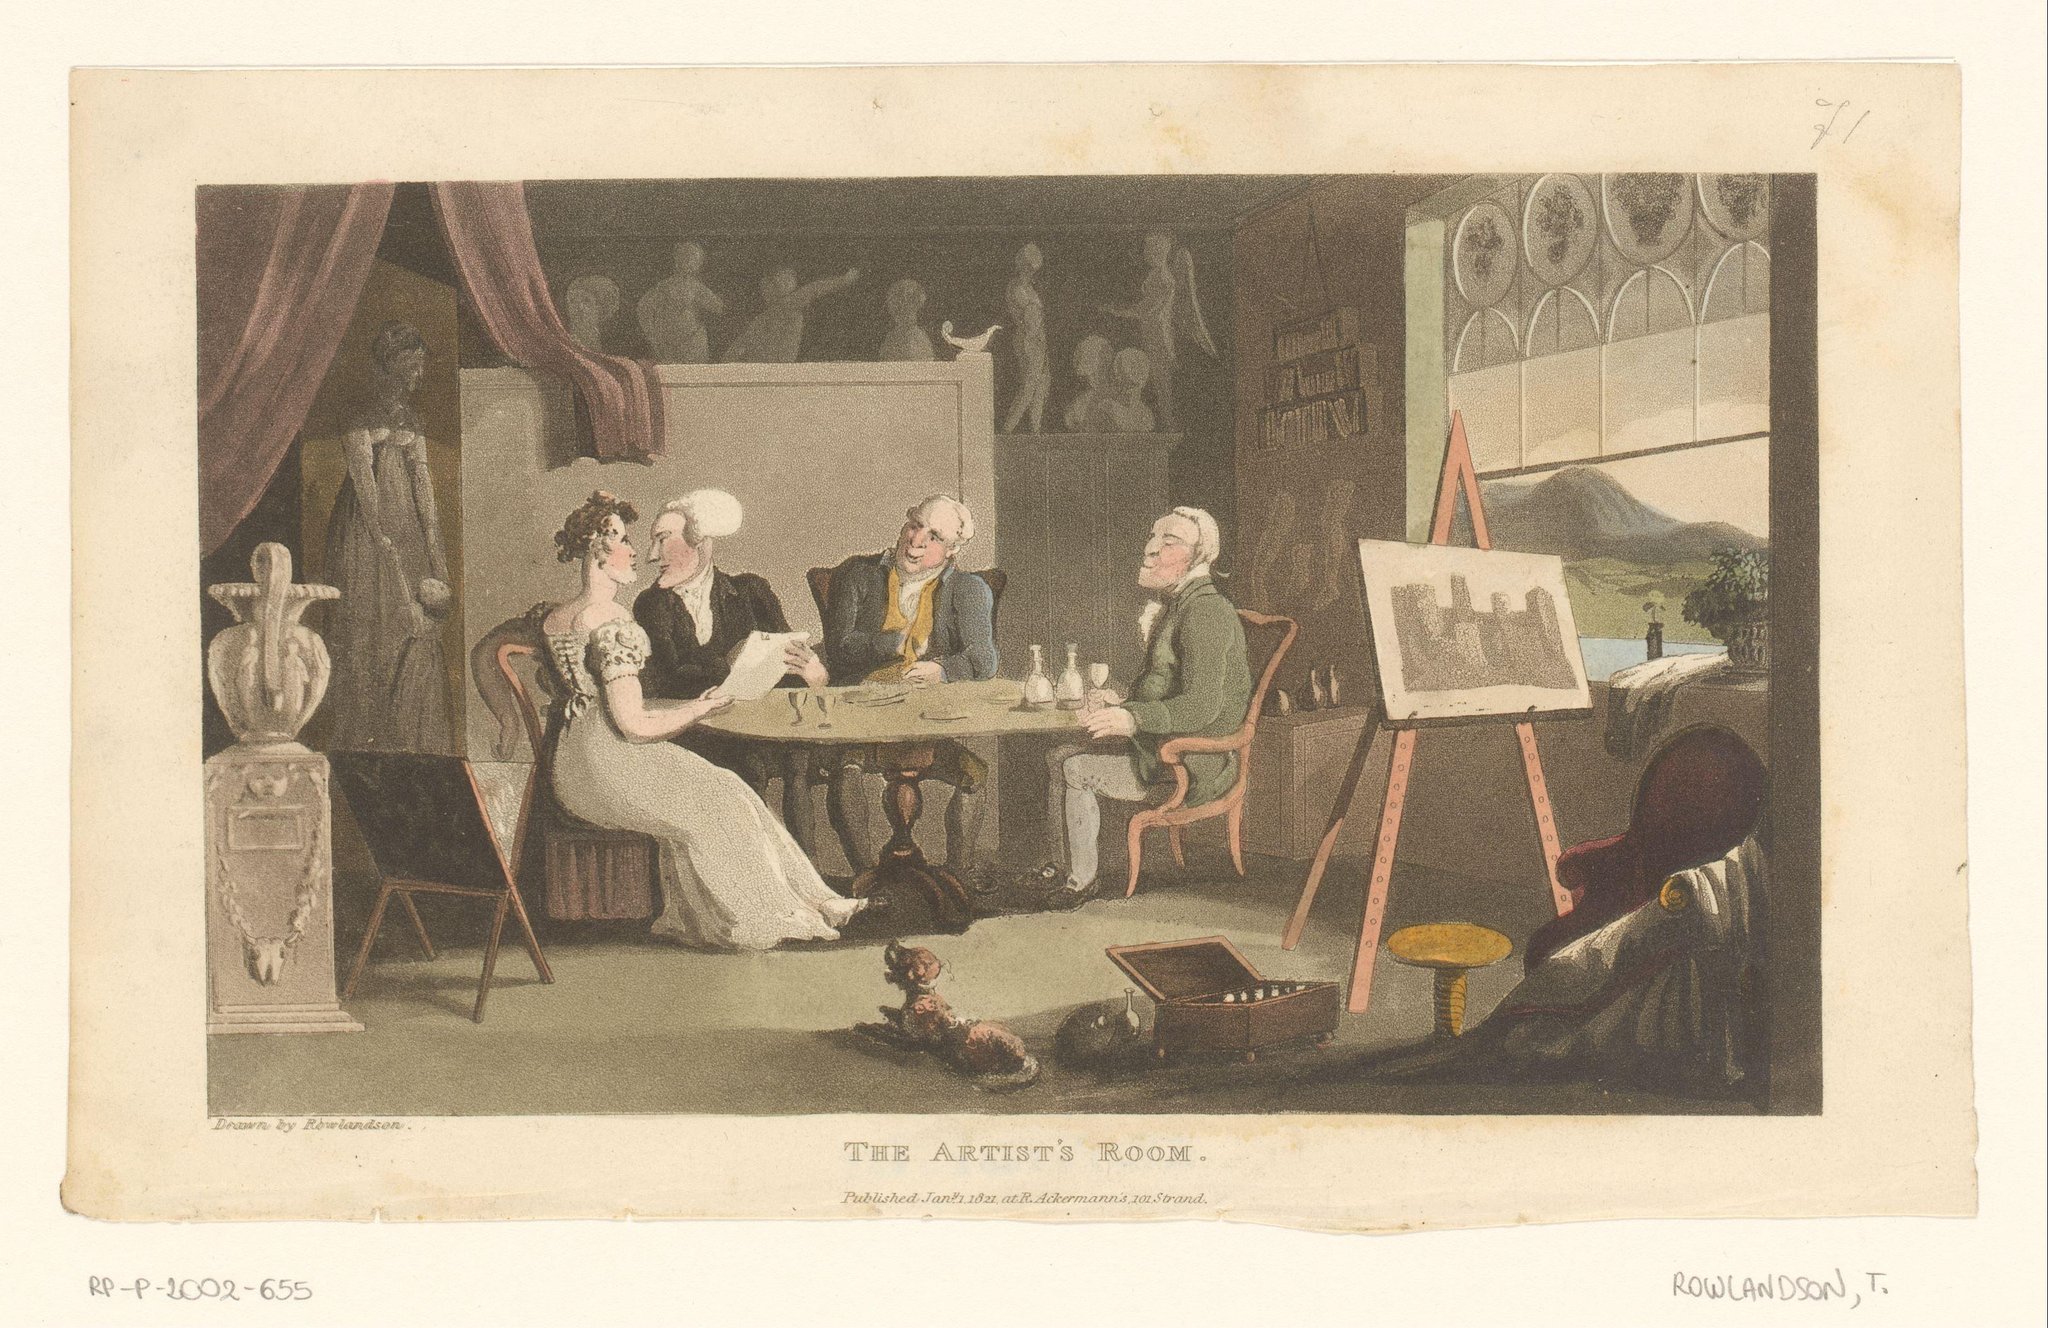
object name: print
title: Doctor Syntax in het atelier van een kunstenaar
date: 1801-1821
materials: paper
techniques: aquatint, etching, hand coloring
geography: london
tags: glass of wine, sculpture, picture, painting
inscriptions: collector's mark: Lugt 2228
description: Prent ook gebruikt in: Combe, William. The Third Tour of Doctor Syntax, in Search of a Wife: A Poem. Londen: Rudolph Ackermann, 1821.